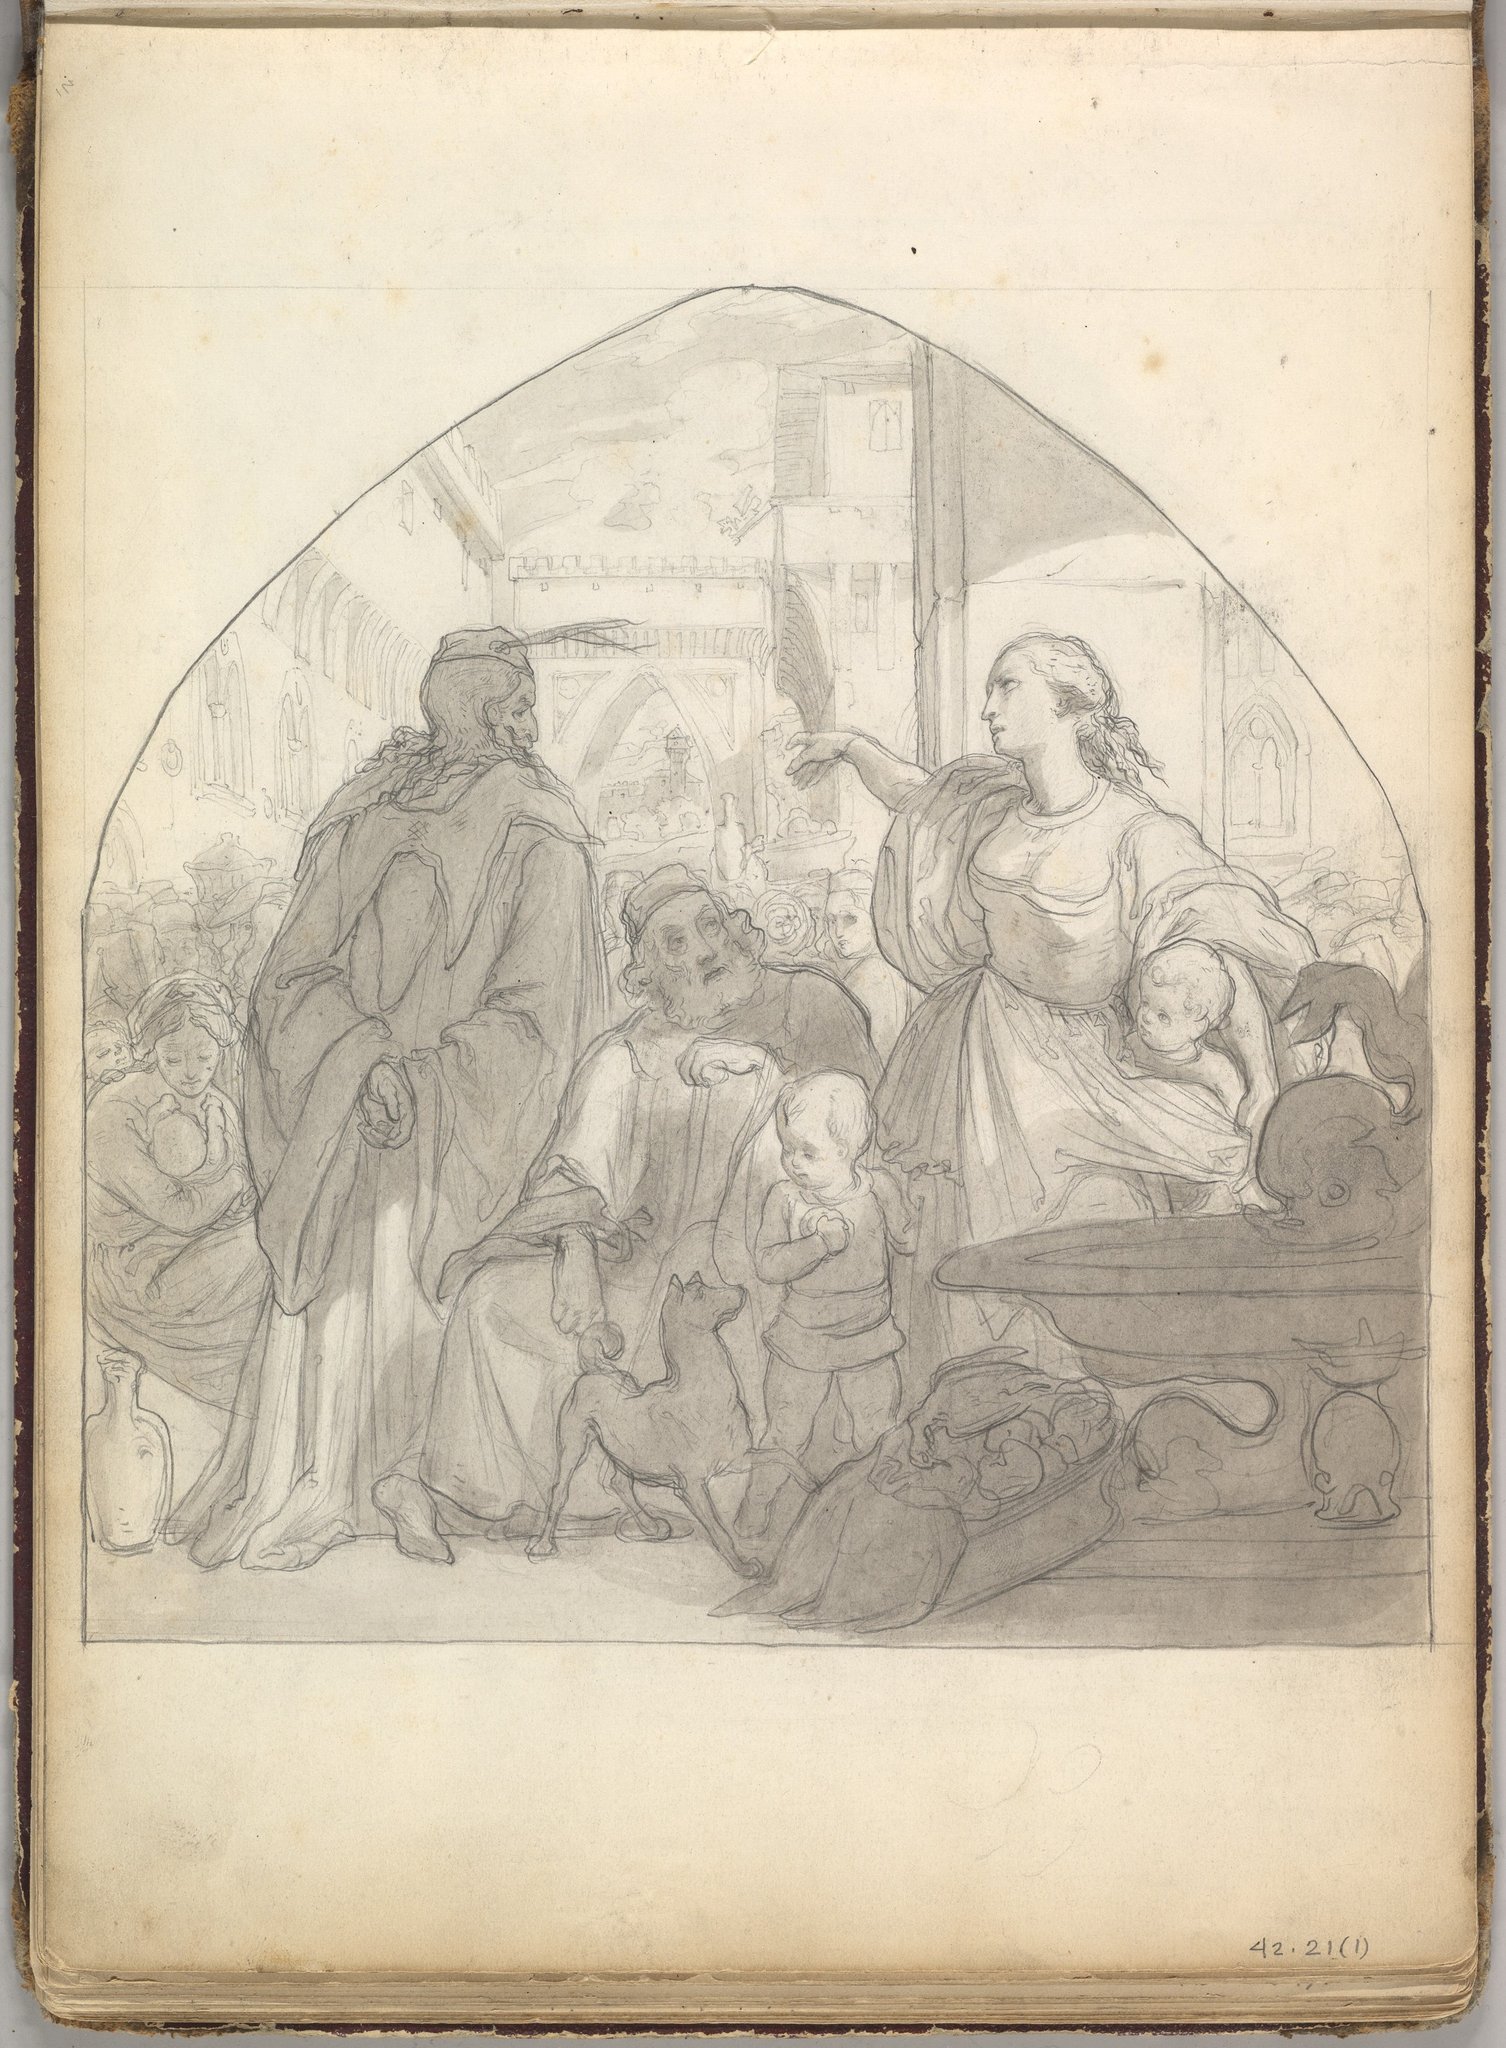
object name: drawing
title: Scene in an Italian City with Figures Near a Fountain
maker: frederic, lord leighton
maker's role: artist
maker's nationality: british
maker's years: 1830-1896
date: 1849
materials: graphite, ink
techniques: brush, wash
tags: fountains,children,men,women,dogs